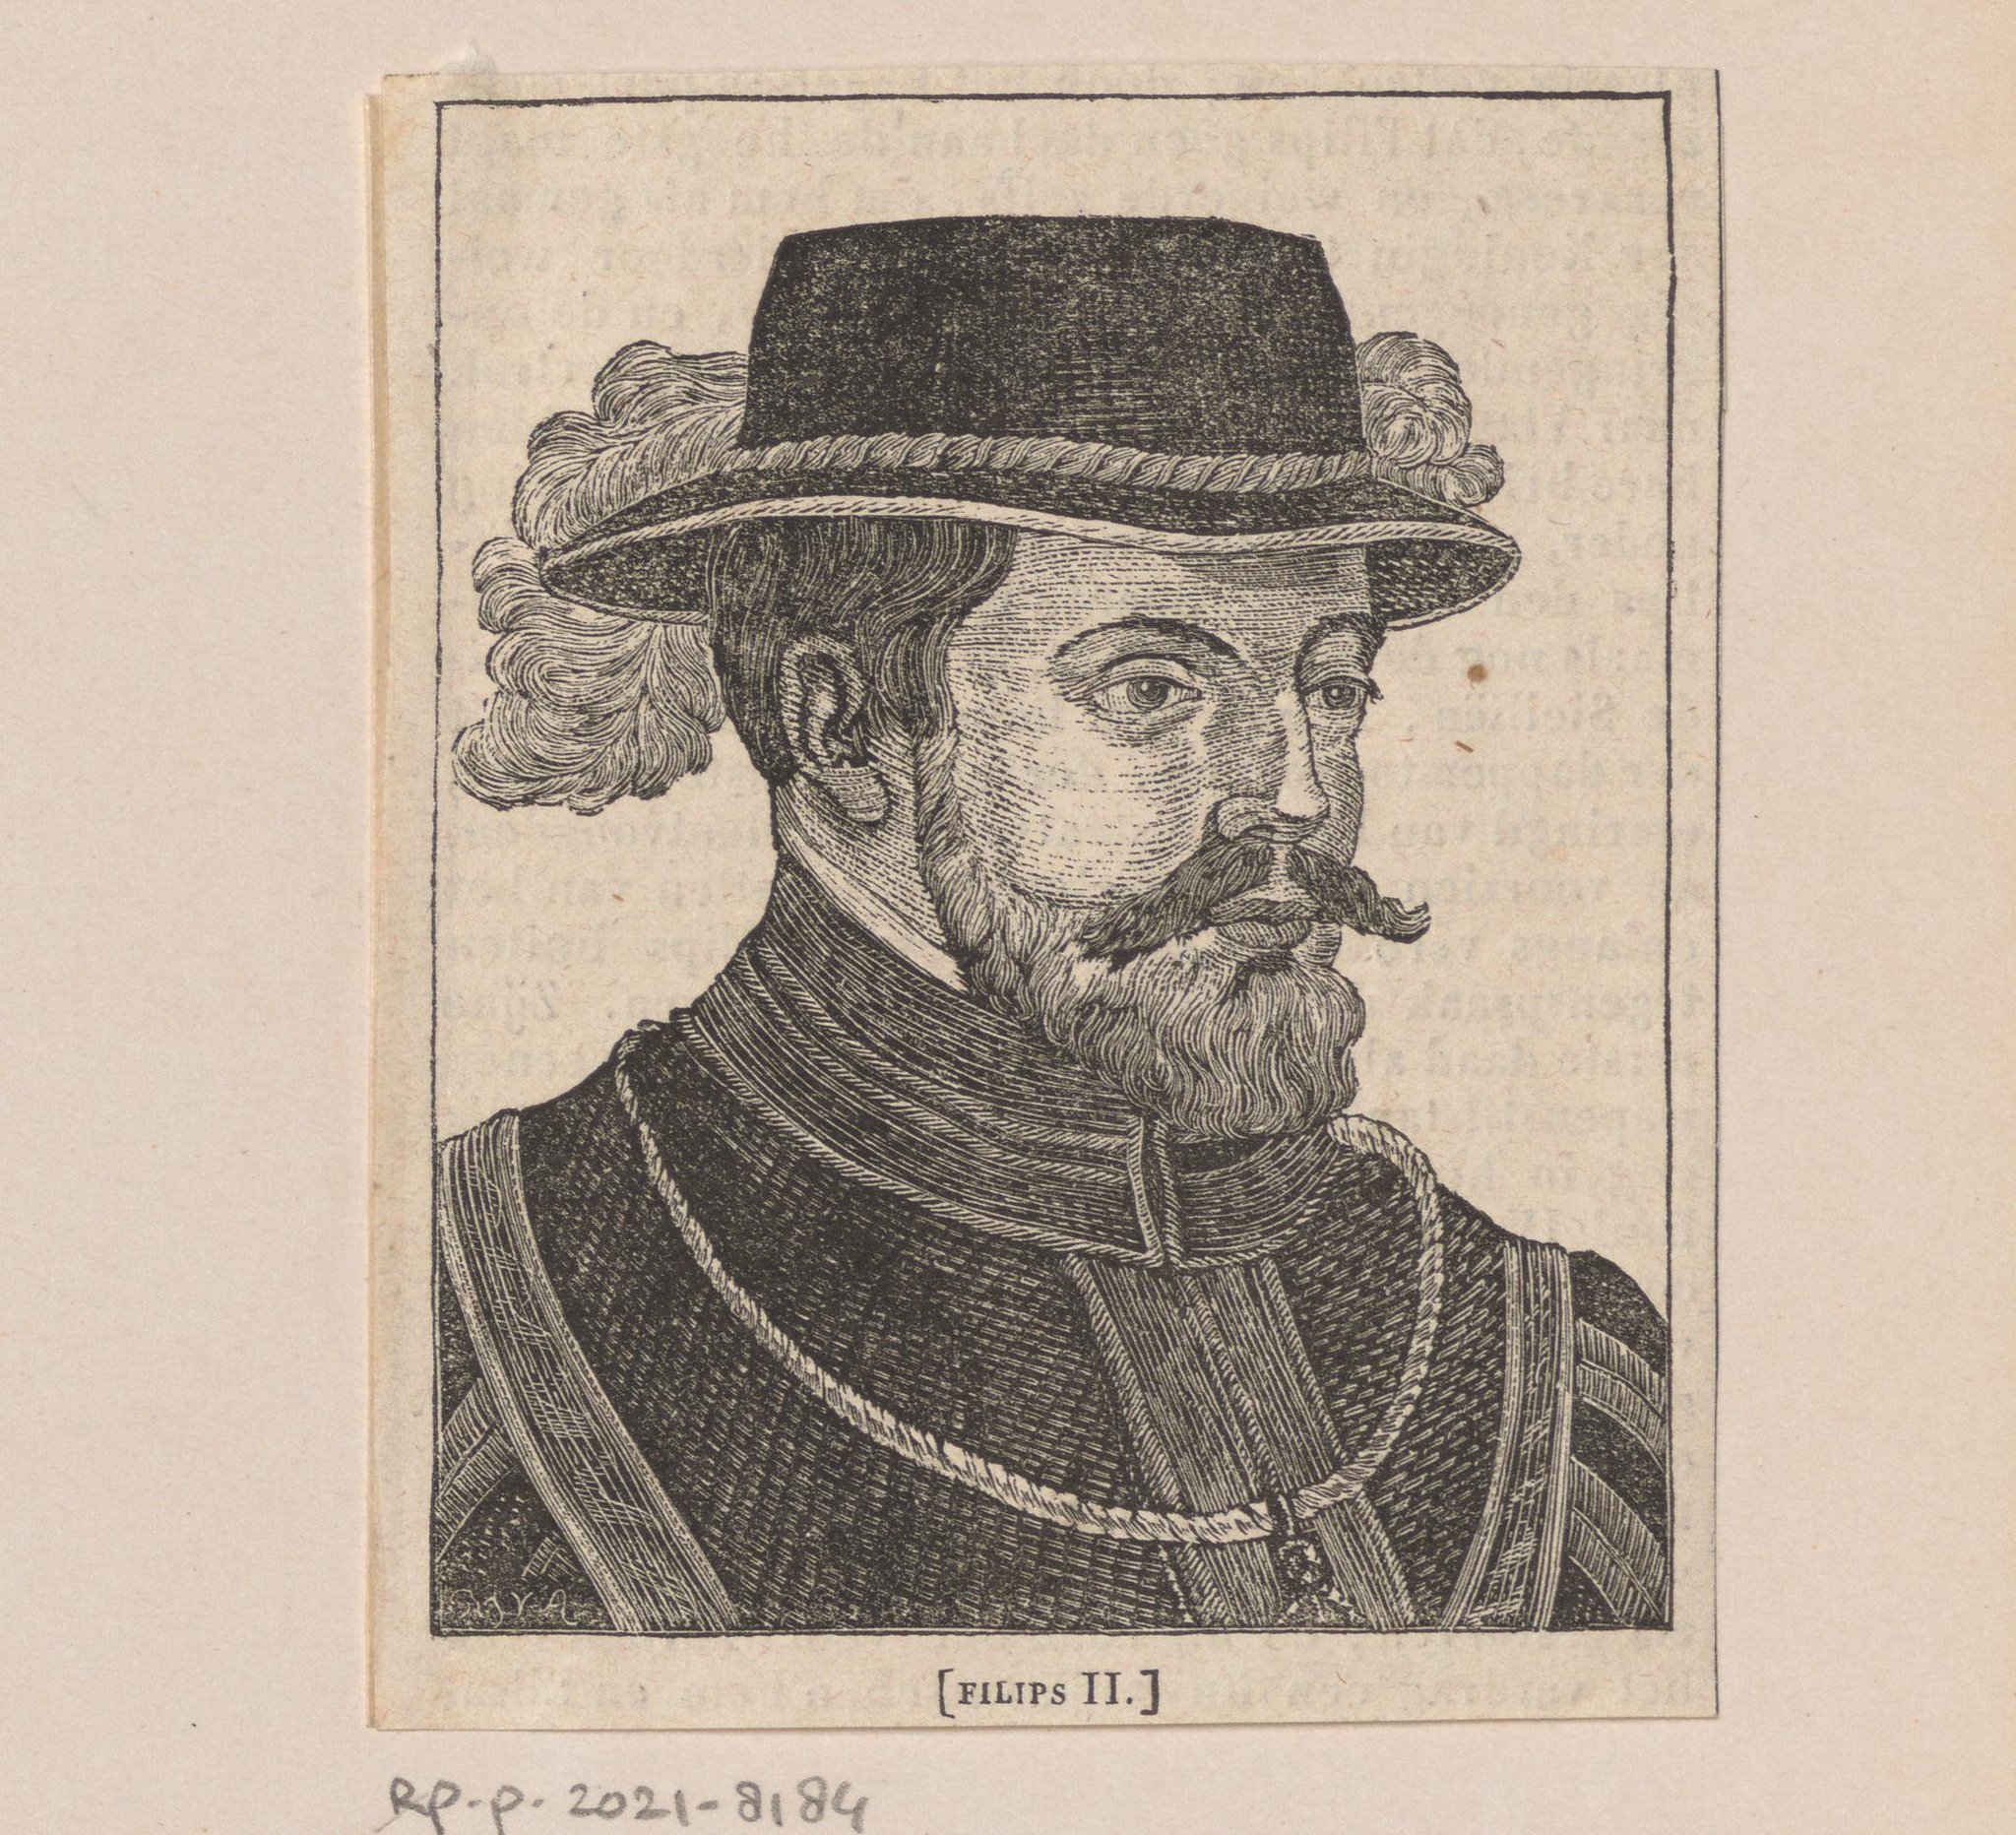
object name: print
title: Portret van Filips II, koning van Spanje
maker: Anonymous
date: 1836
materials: paper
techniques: letterpress printing, engraving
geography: amsterdam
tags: philip ii of spain, head-gear, historical persons, knighthood order of the golden fleece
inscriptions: initials: ‘[R]JVA’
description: Prent uit: Het Nederlandsch magazijn 1 (1836).